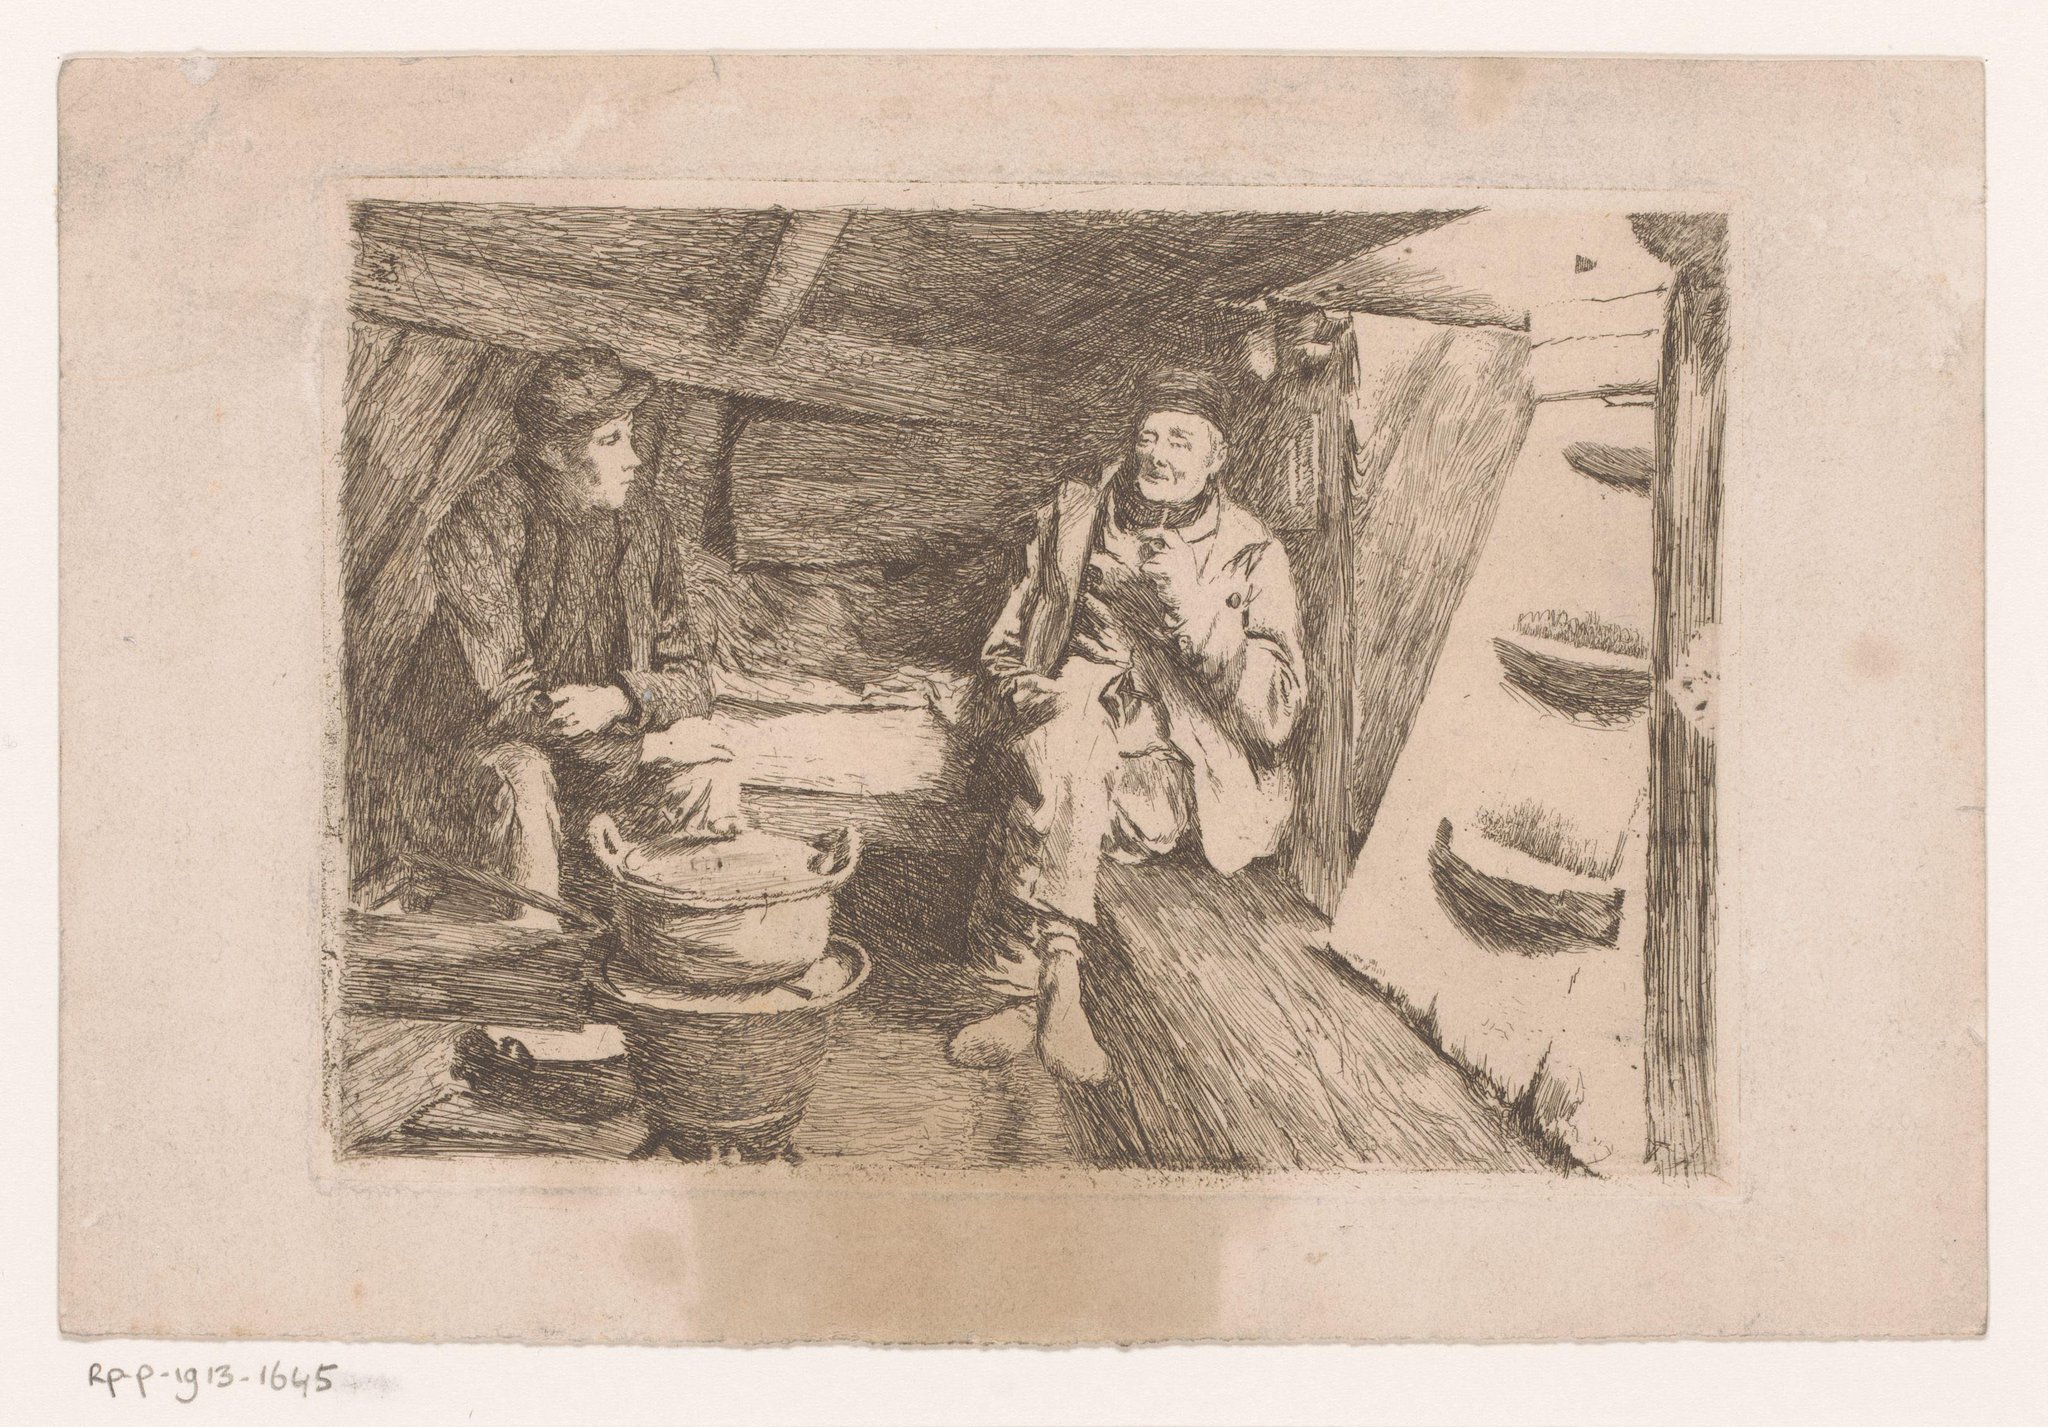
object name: print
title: Twee mannen in een lage ruimte rondom een kookpot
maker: charles mertens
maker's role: print maker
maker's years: 1865-1919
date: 1892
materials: paper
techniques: etching, intaglio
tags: adult man (+ two persons), staircase, kitchen-utensils: pot, interior ~ representation of a building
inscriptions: collector's mark: Lugt 2228